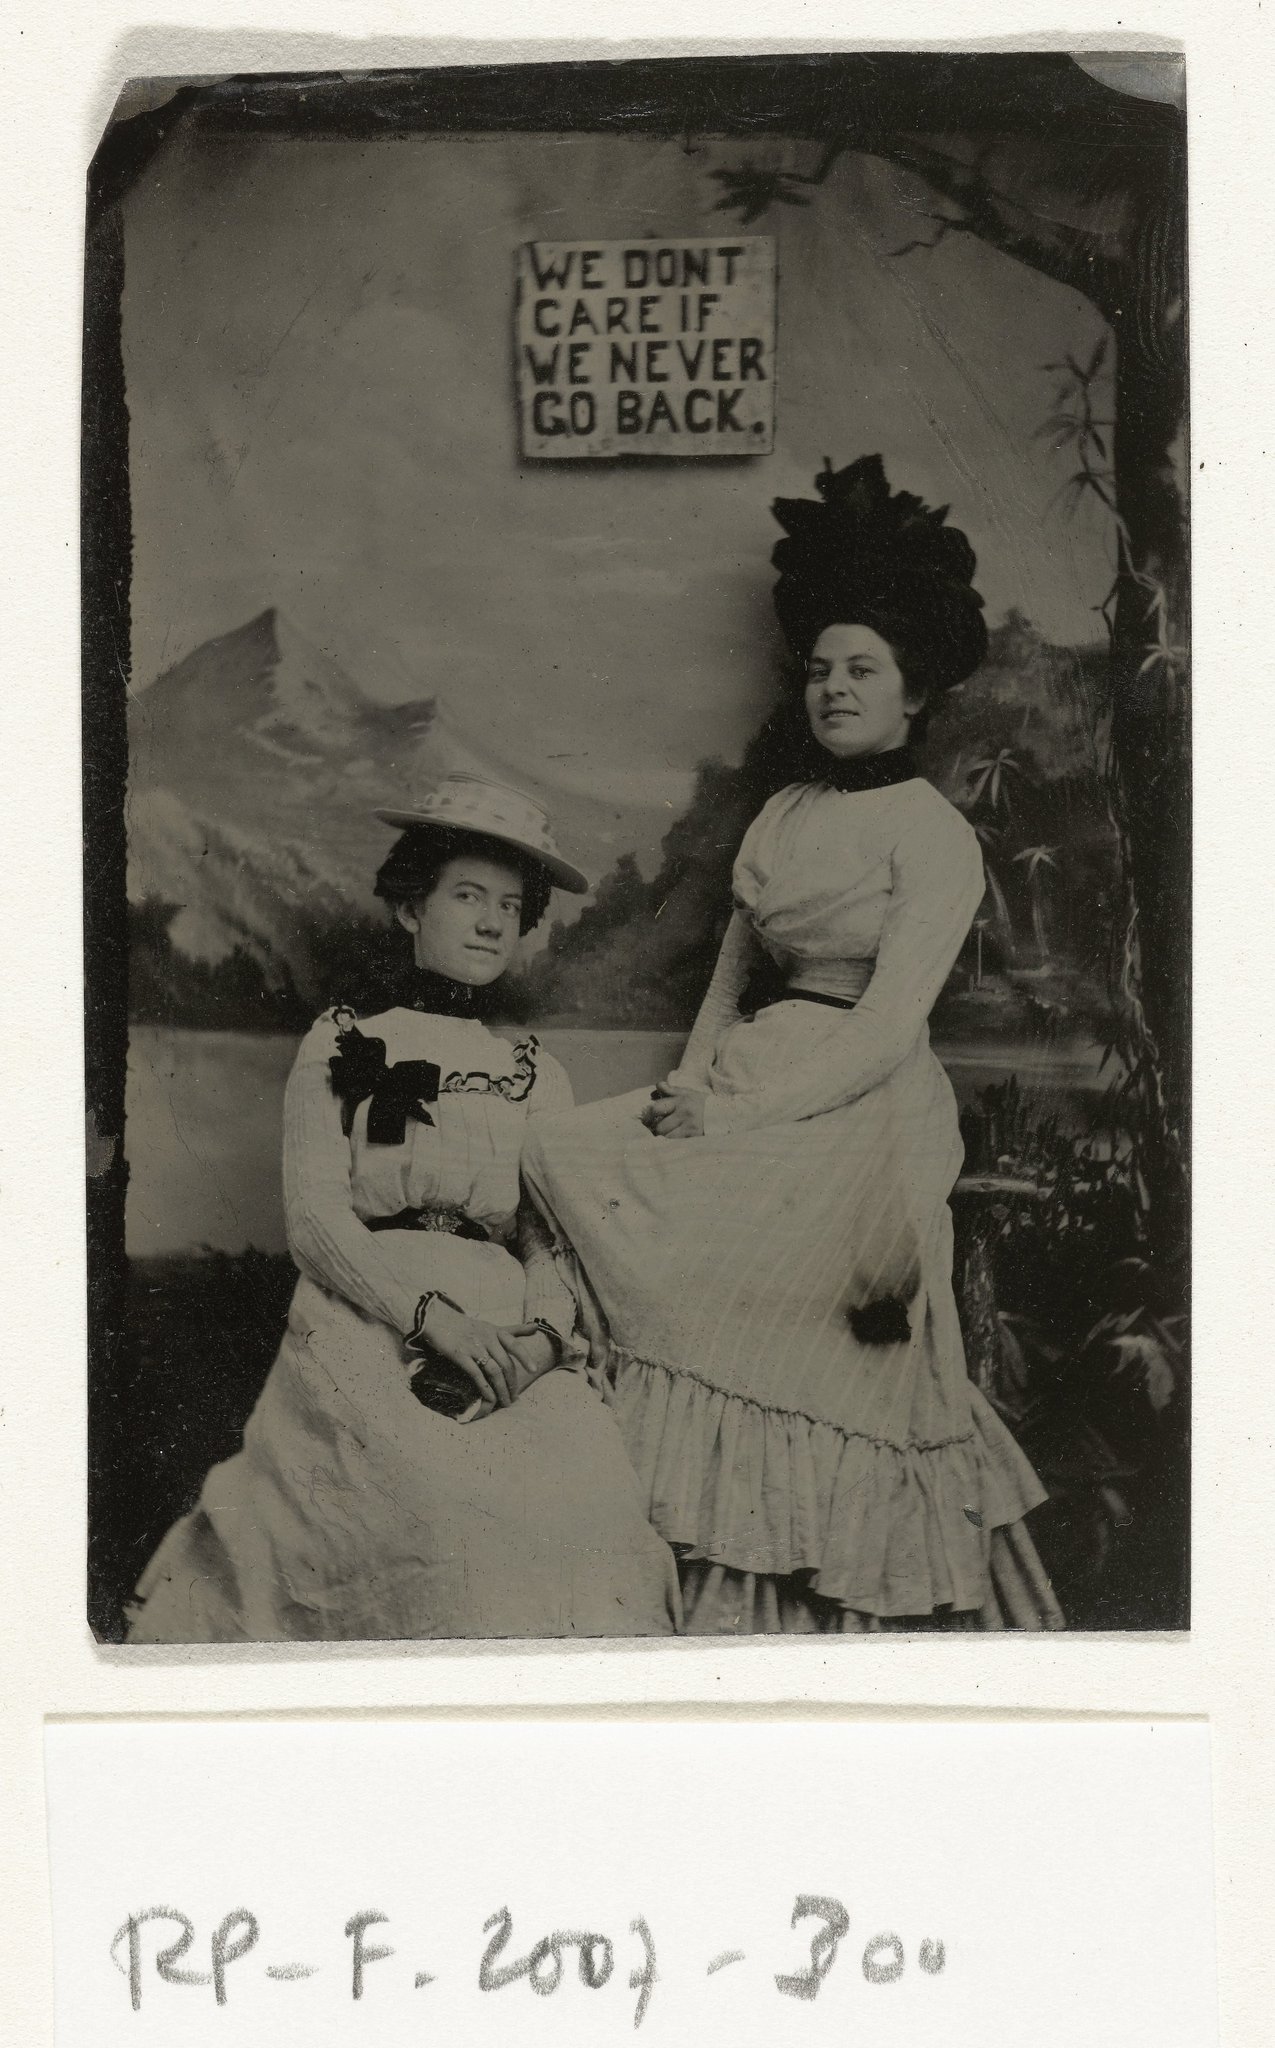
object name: photograph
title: Portrait of two women, one standing and one sitting, in front of a painted backdrop (mountains) with the text WE DON'T CARE IF WE NEVER GO BACK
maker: Anonymous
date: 1895-1910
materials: metal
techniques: ferrotyping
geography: united states